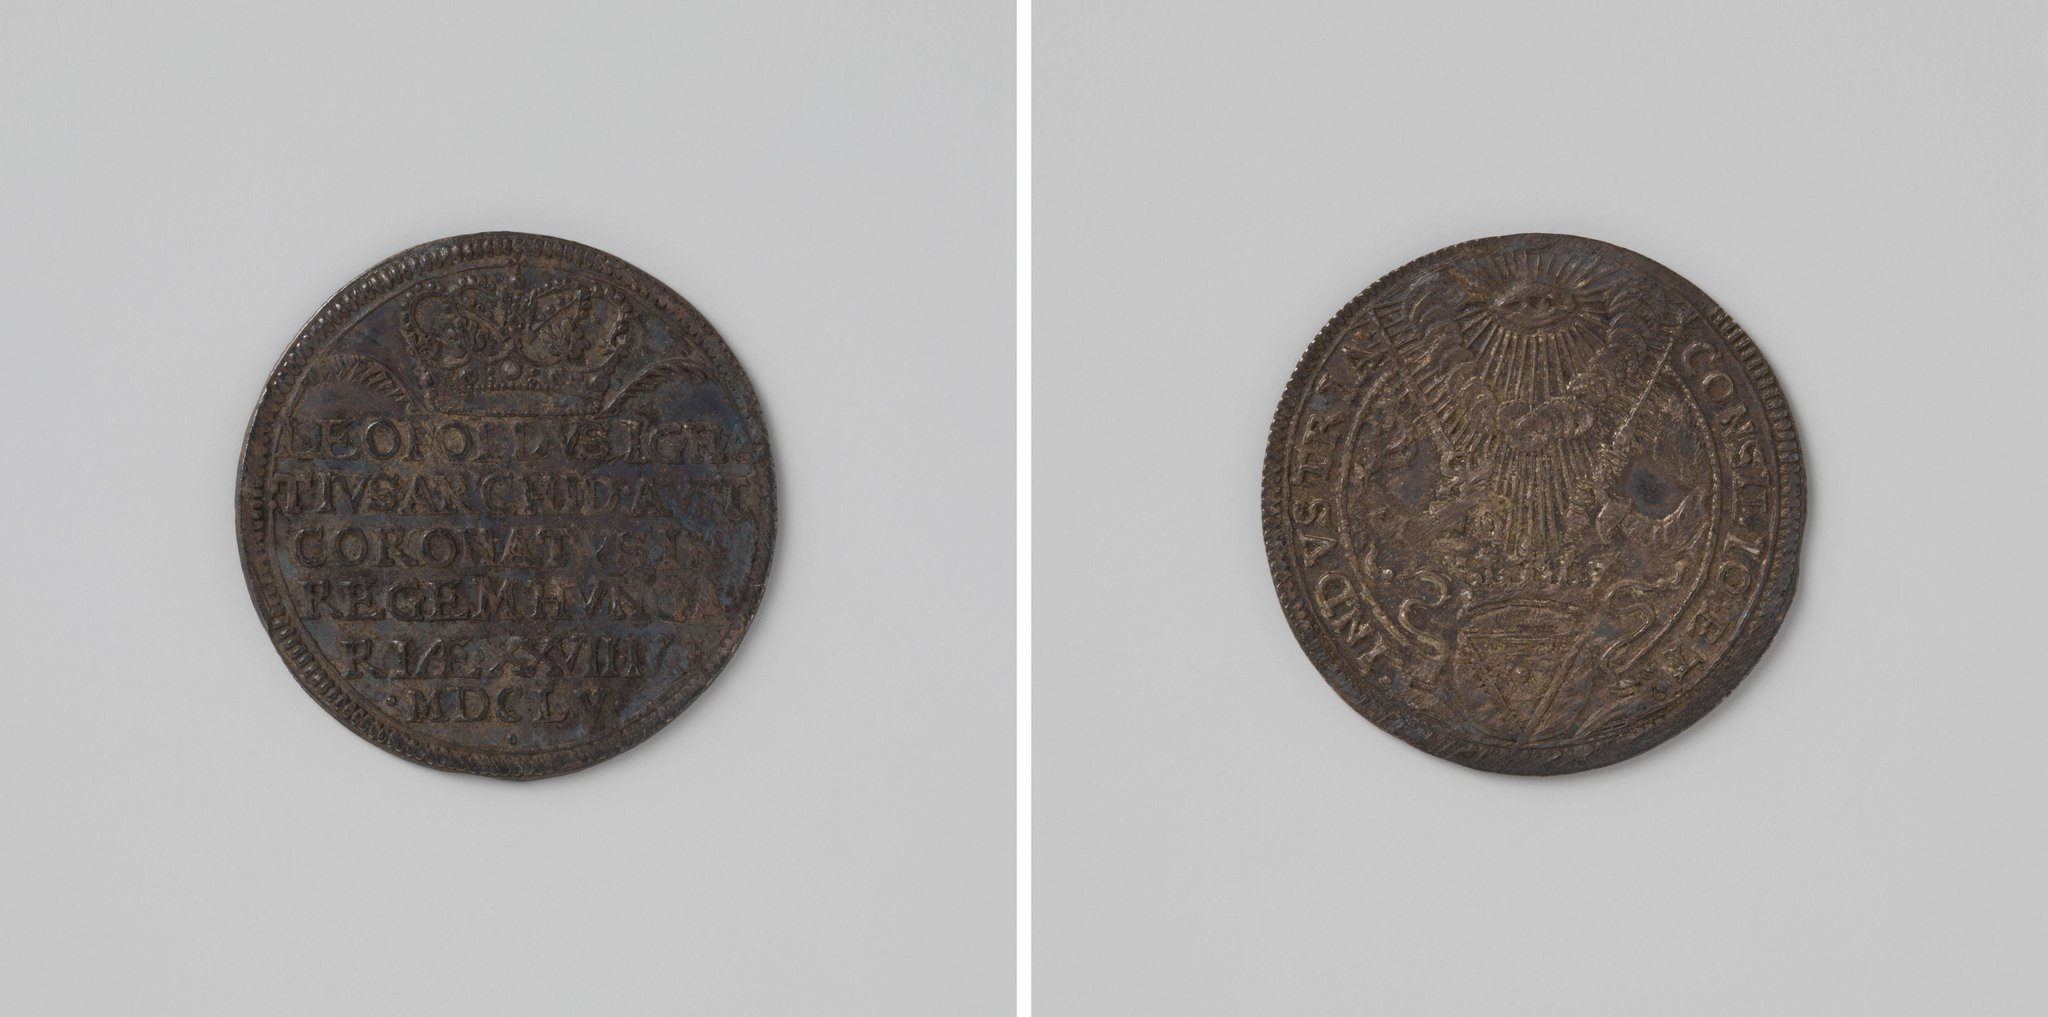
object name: history medal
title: Leopold I ingehuldigd als koning van Hongarije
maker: Anonymous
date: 1655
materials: silver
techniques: striking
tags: leopold i (keizer van duitsland)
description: Zilveren penning. Voorzijde: opschrift onder kroon. Keerzijde: onder stralend oog twee handen met zwaarden en gekroond wapenschild binnen omschrift